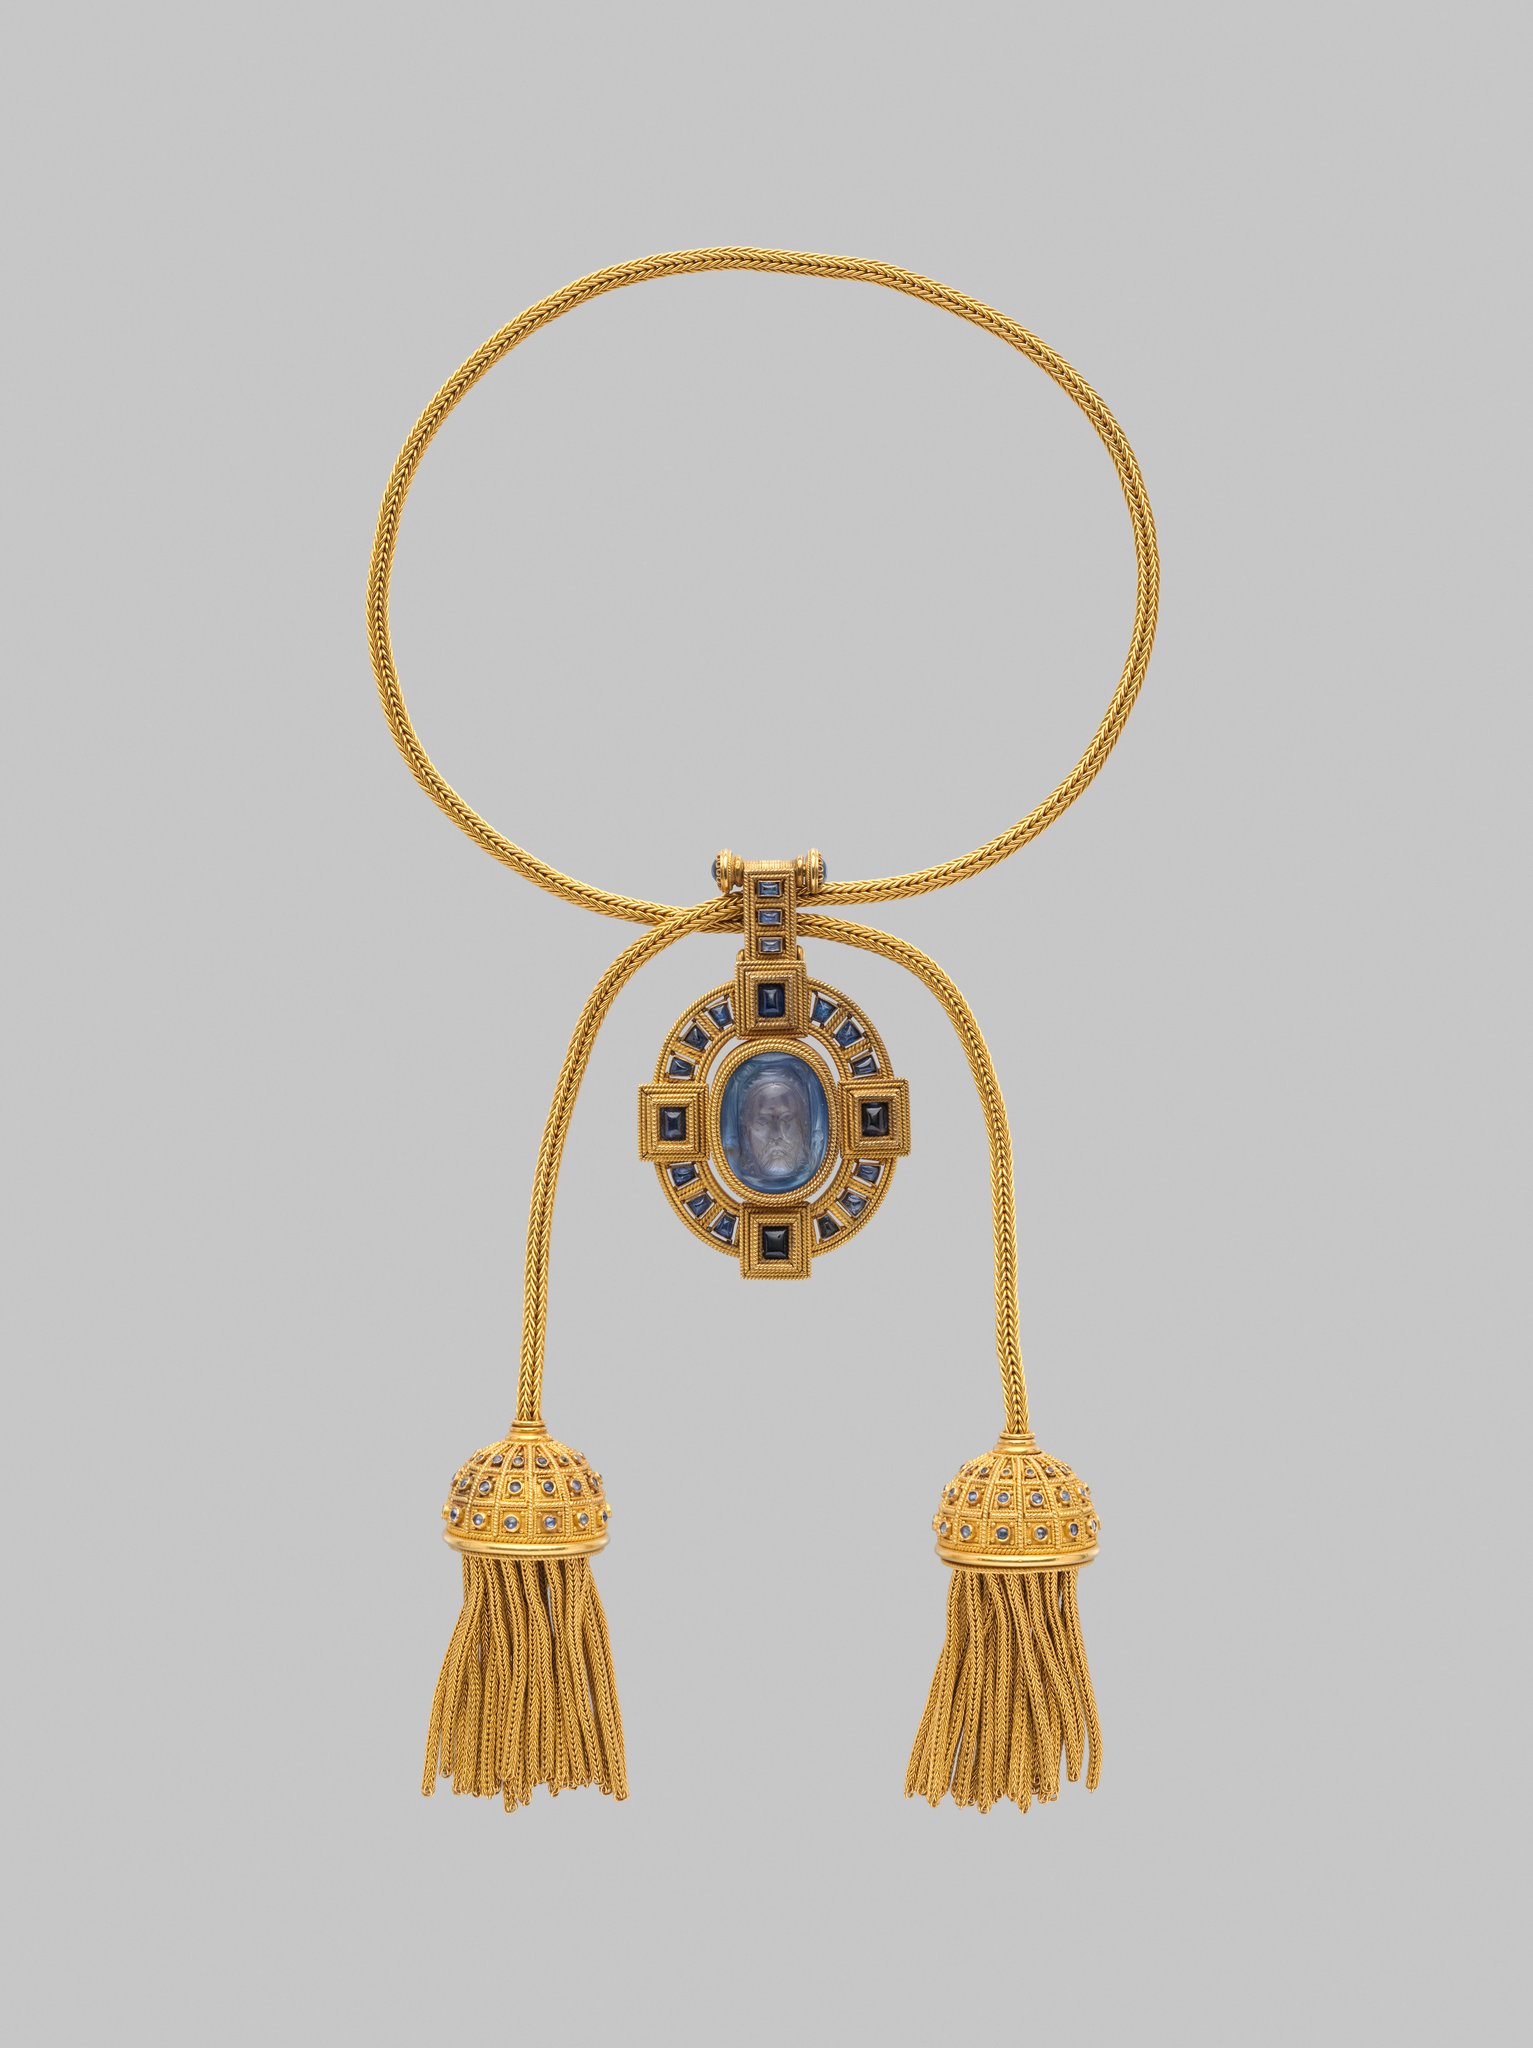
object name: necklace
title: Necklace with cameo of Veronica's Veil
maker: castellani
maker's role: maker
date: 1870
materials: gold, gemstone